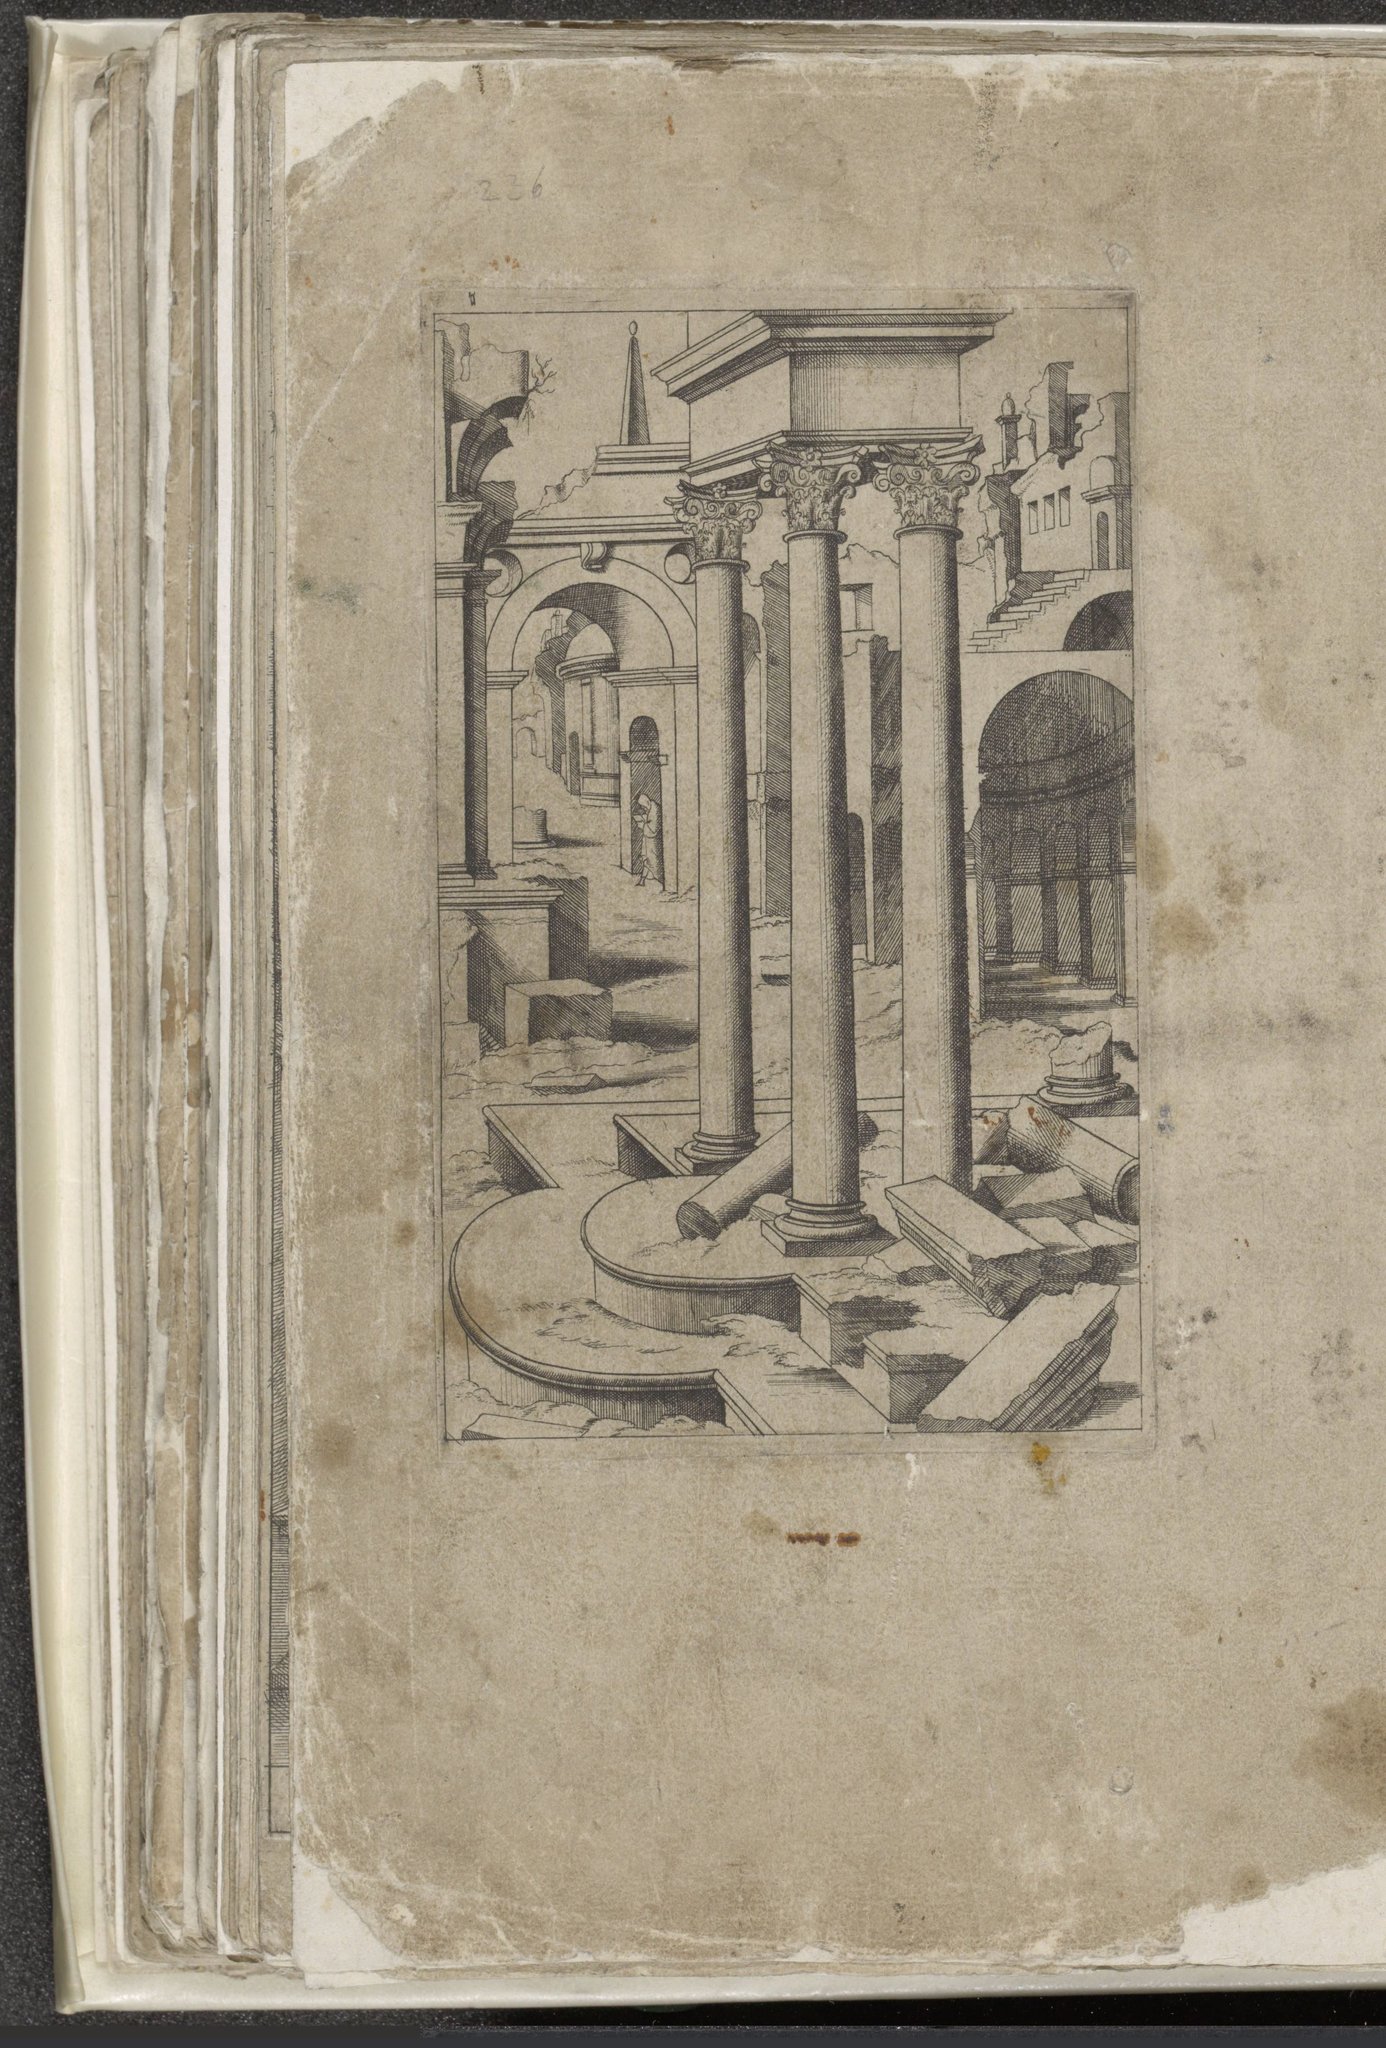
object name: album leaf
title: Drie Korinthische zuilen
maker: Anonymous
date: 1550-1575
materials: paper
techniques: etching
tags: ruin of a building ~ architecture, corinthian order ~ architecture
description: Op de voorgrond staan drie Korinthische zuilen op een verhoging met twee treden. Deze prent maakt deel uit van een album.